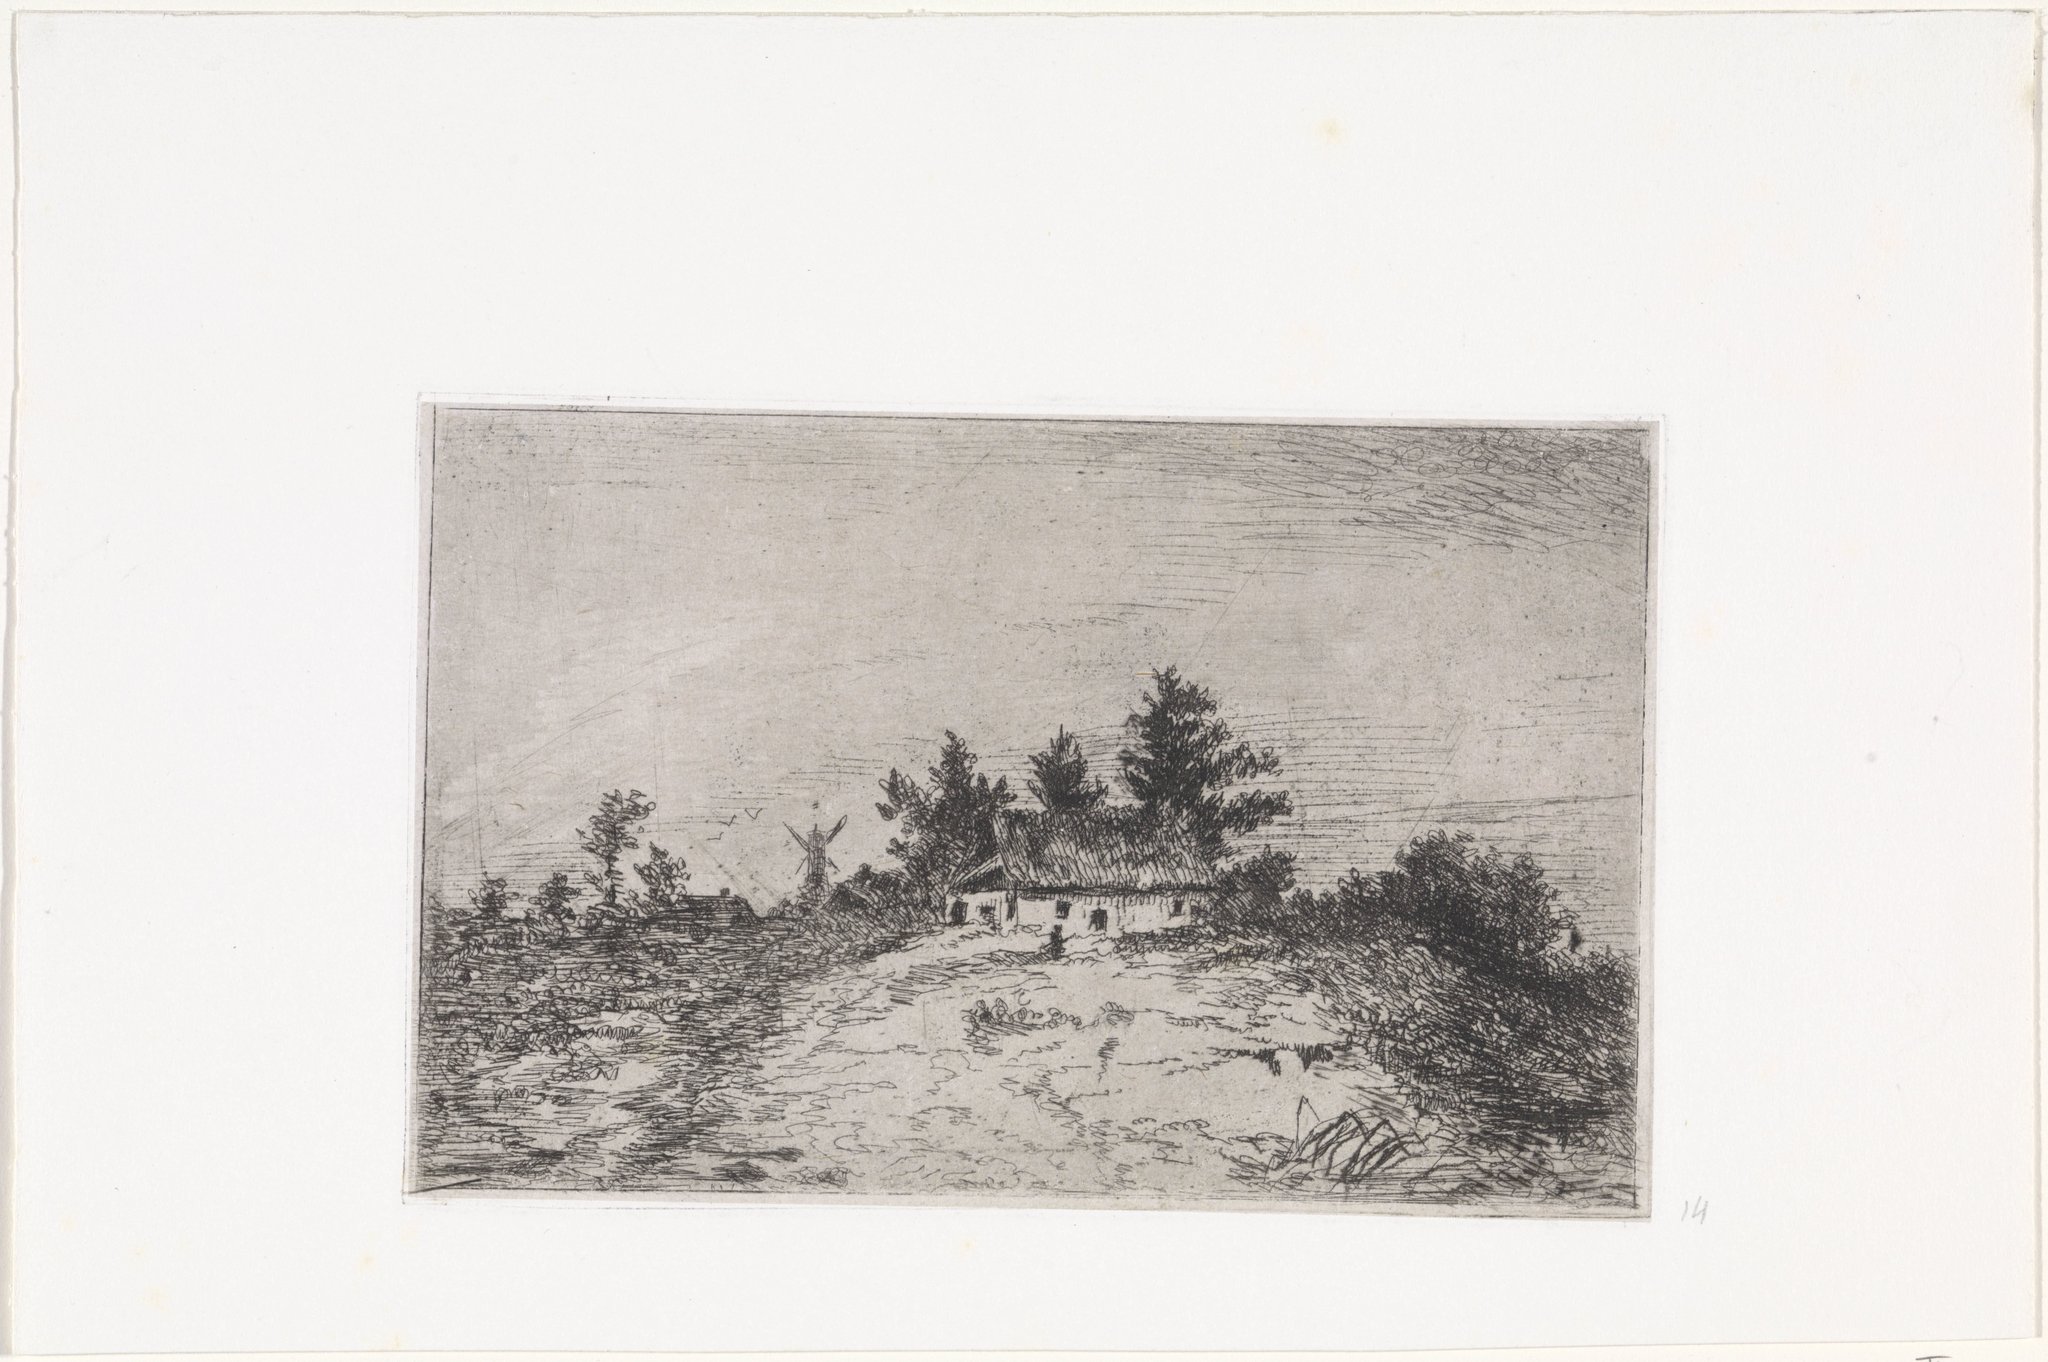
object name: print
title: Gezicht op een rietgedekt huis en nabij gelegen molen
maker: arnoud schaepkens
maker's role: print maker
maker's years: 1816-1904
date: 1855-1904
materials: paper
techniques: drypoint, etching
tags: windmill in landscape, cottage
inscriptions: collector's mark: Lugt 2228